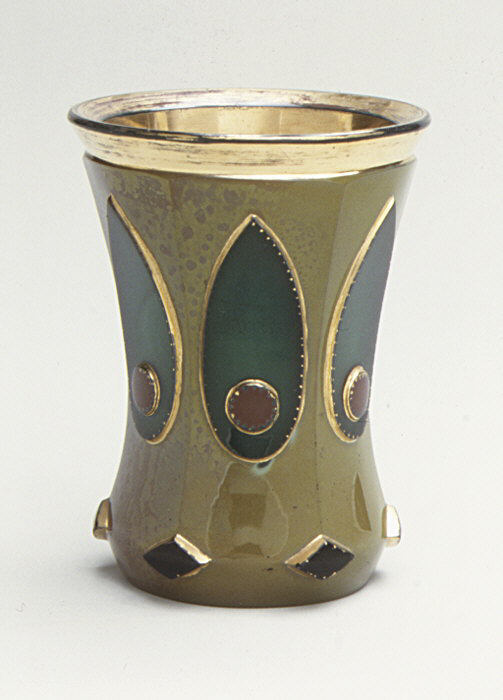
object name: beaker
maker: friedrich egermann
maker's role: maker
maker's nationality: czech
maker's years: 1777-1864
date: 1840-1850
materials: gilt, glass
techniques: cutting, engraving, polish